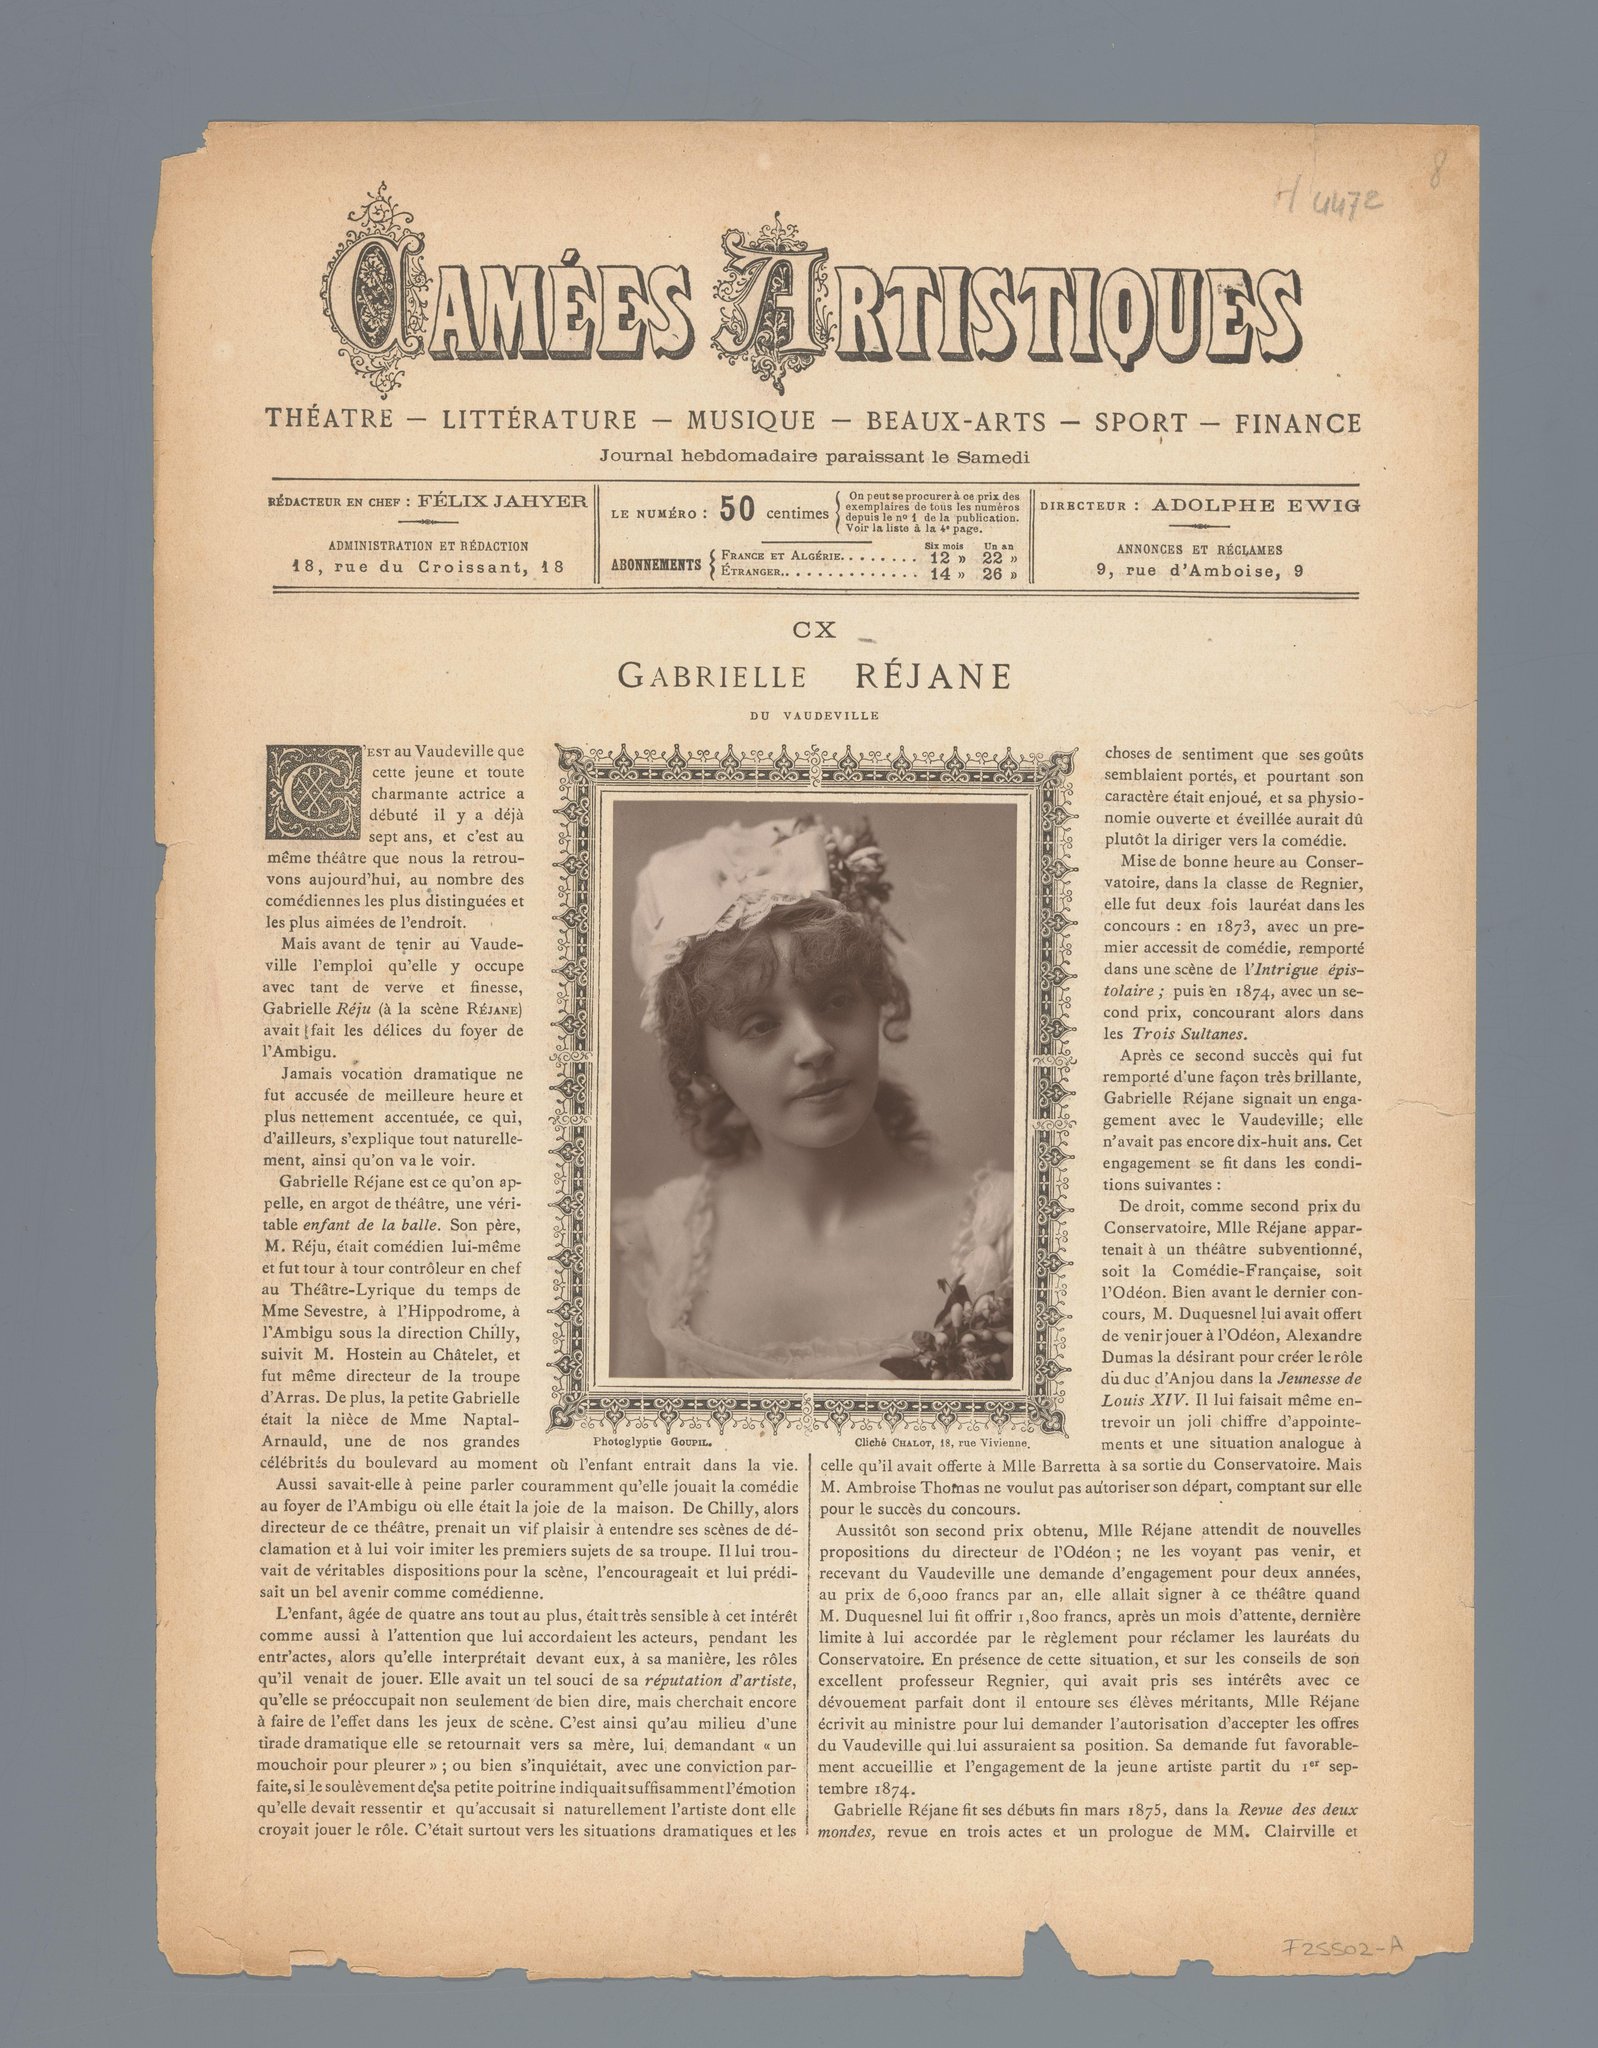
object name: magazine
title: Camées artistiques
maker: félix jahyer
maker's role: journalist, redacteur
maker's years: 1834-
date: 1880-1883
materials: linen, paper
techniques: printing, woodburytype